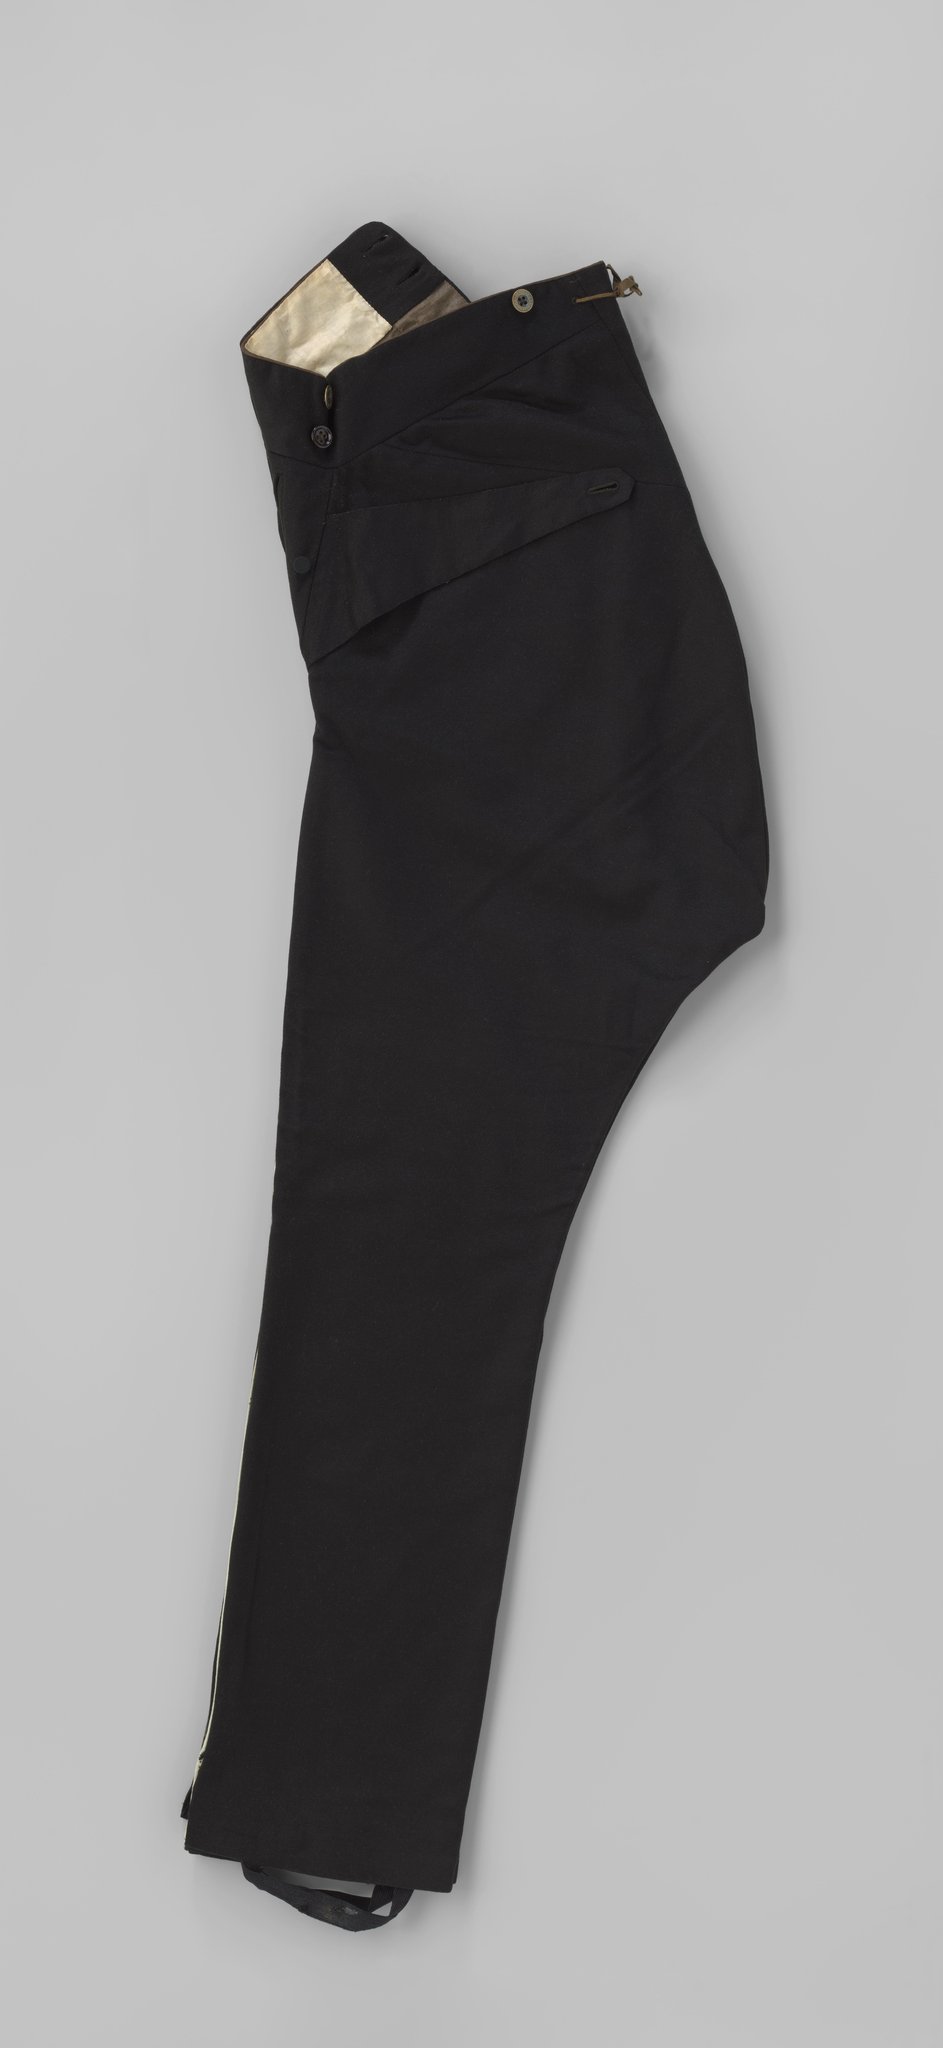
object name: kapiteinsuniform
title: Broek van zwart laken met klep over het hele front, waaronder twee zakken met staande ingang en kleiner zakje rechts , tailleband met o.a. oogjesknopen en koper en witte bies, onderdeel van een schutterij-uniform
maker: i.p. becker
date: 1834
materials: textile, copper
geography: amsterdam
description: Broek van zwart laken met klep over het hele front, waaronder twee zakken met staande ingang en kleiner zakje rechts , tailleband met o.a. oogjesknopen en koper en witte bies, onderdeel van een schutterij-uniform. Adres: I.P. Becker/Amsterdam.